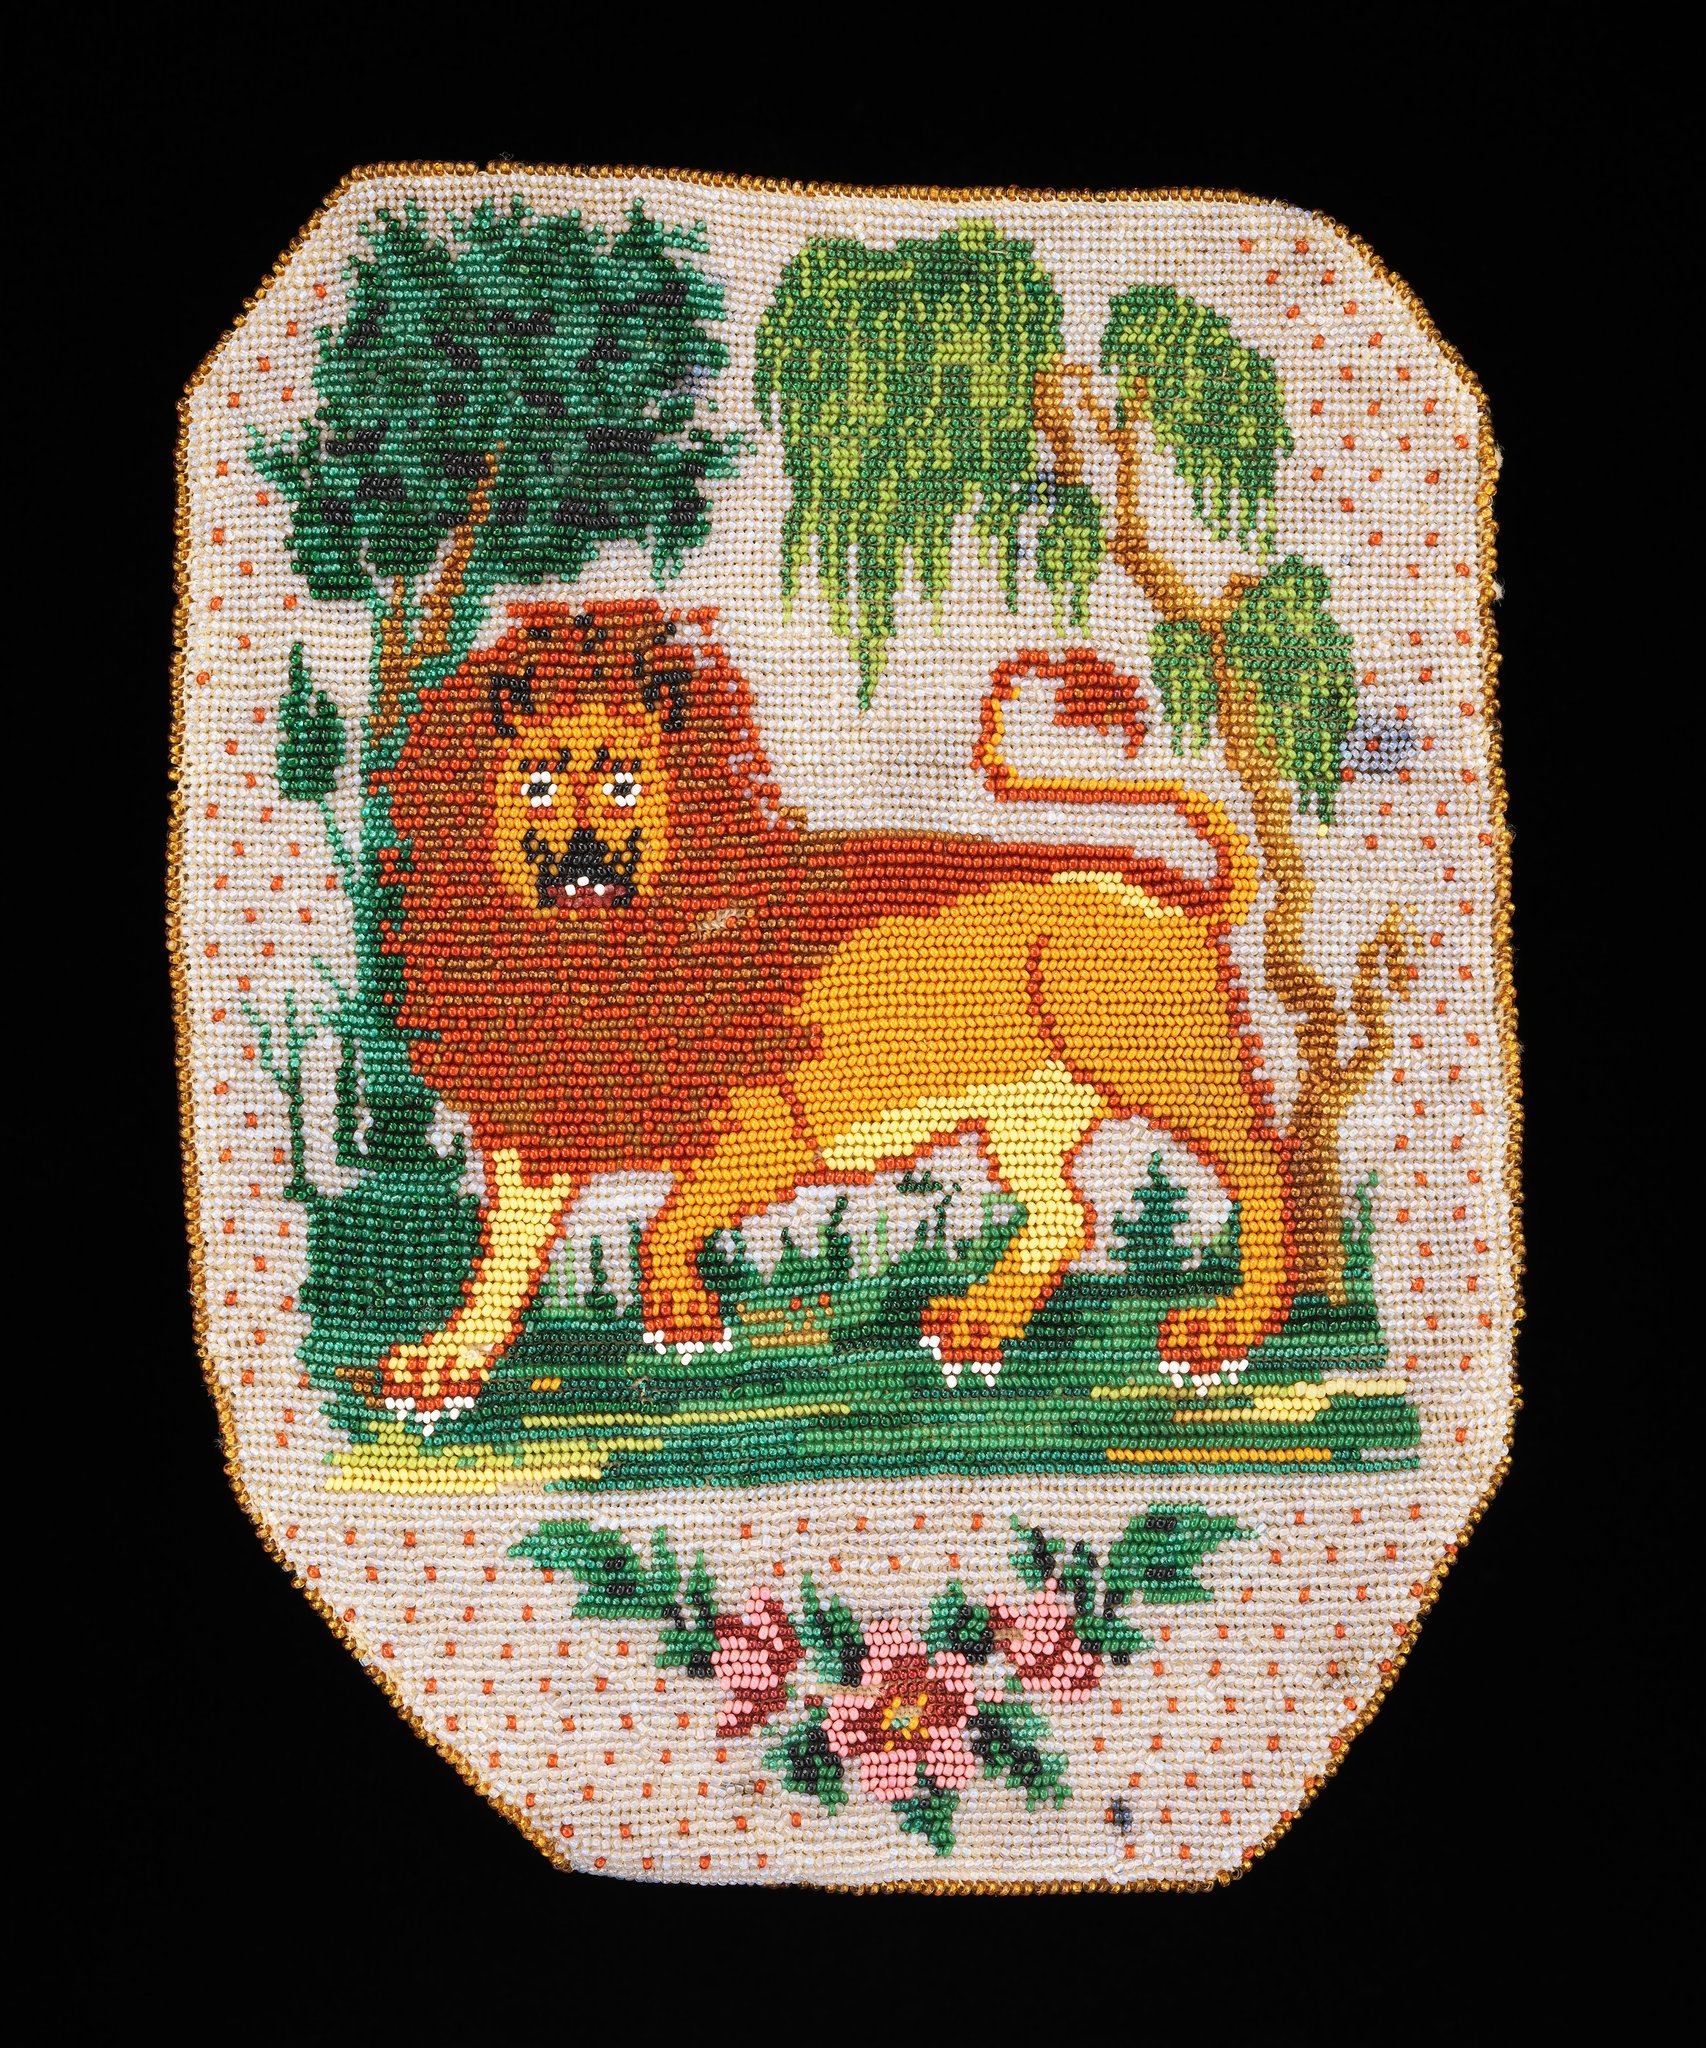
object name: bag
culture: mexican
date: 1830-1860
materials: glass, linen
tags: lions